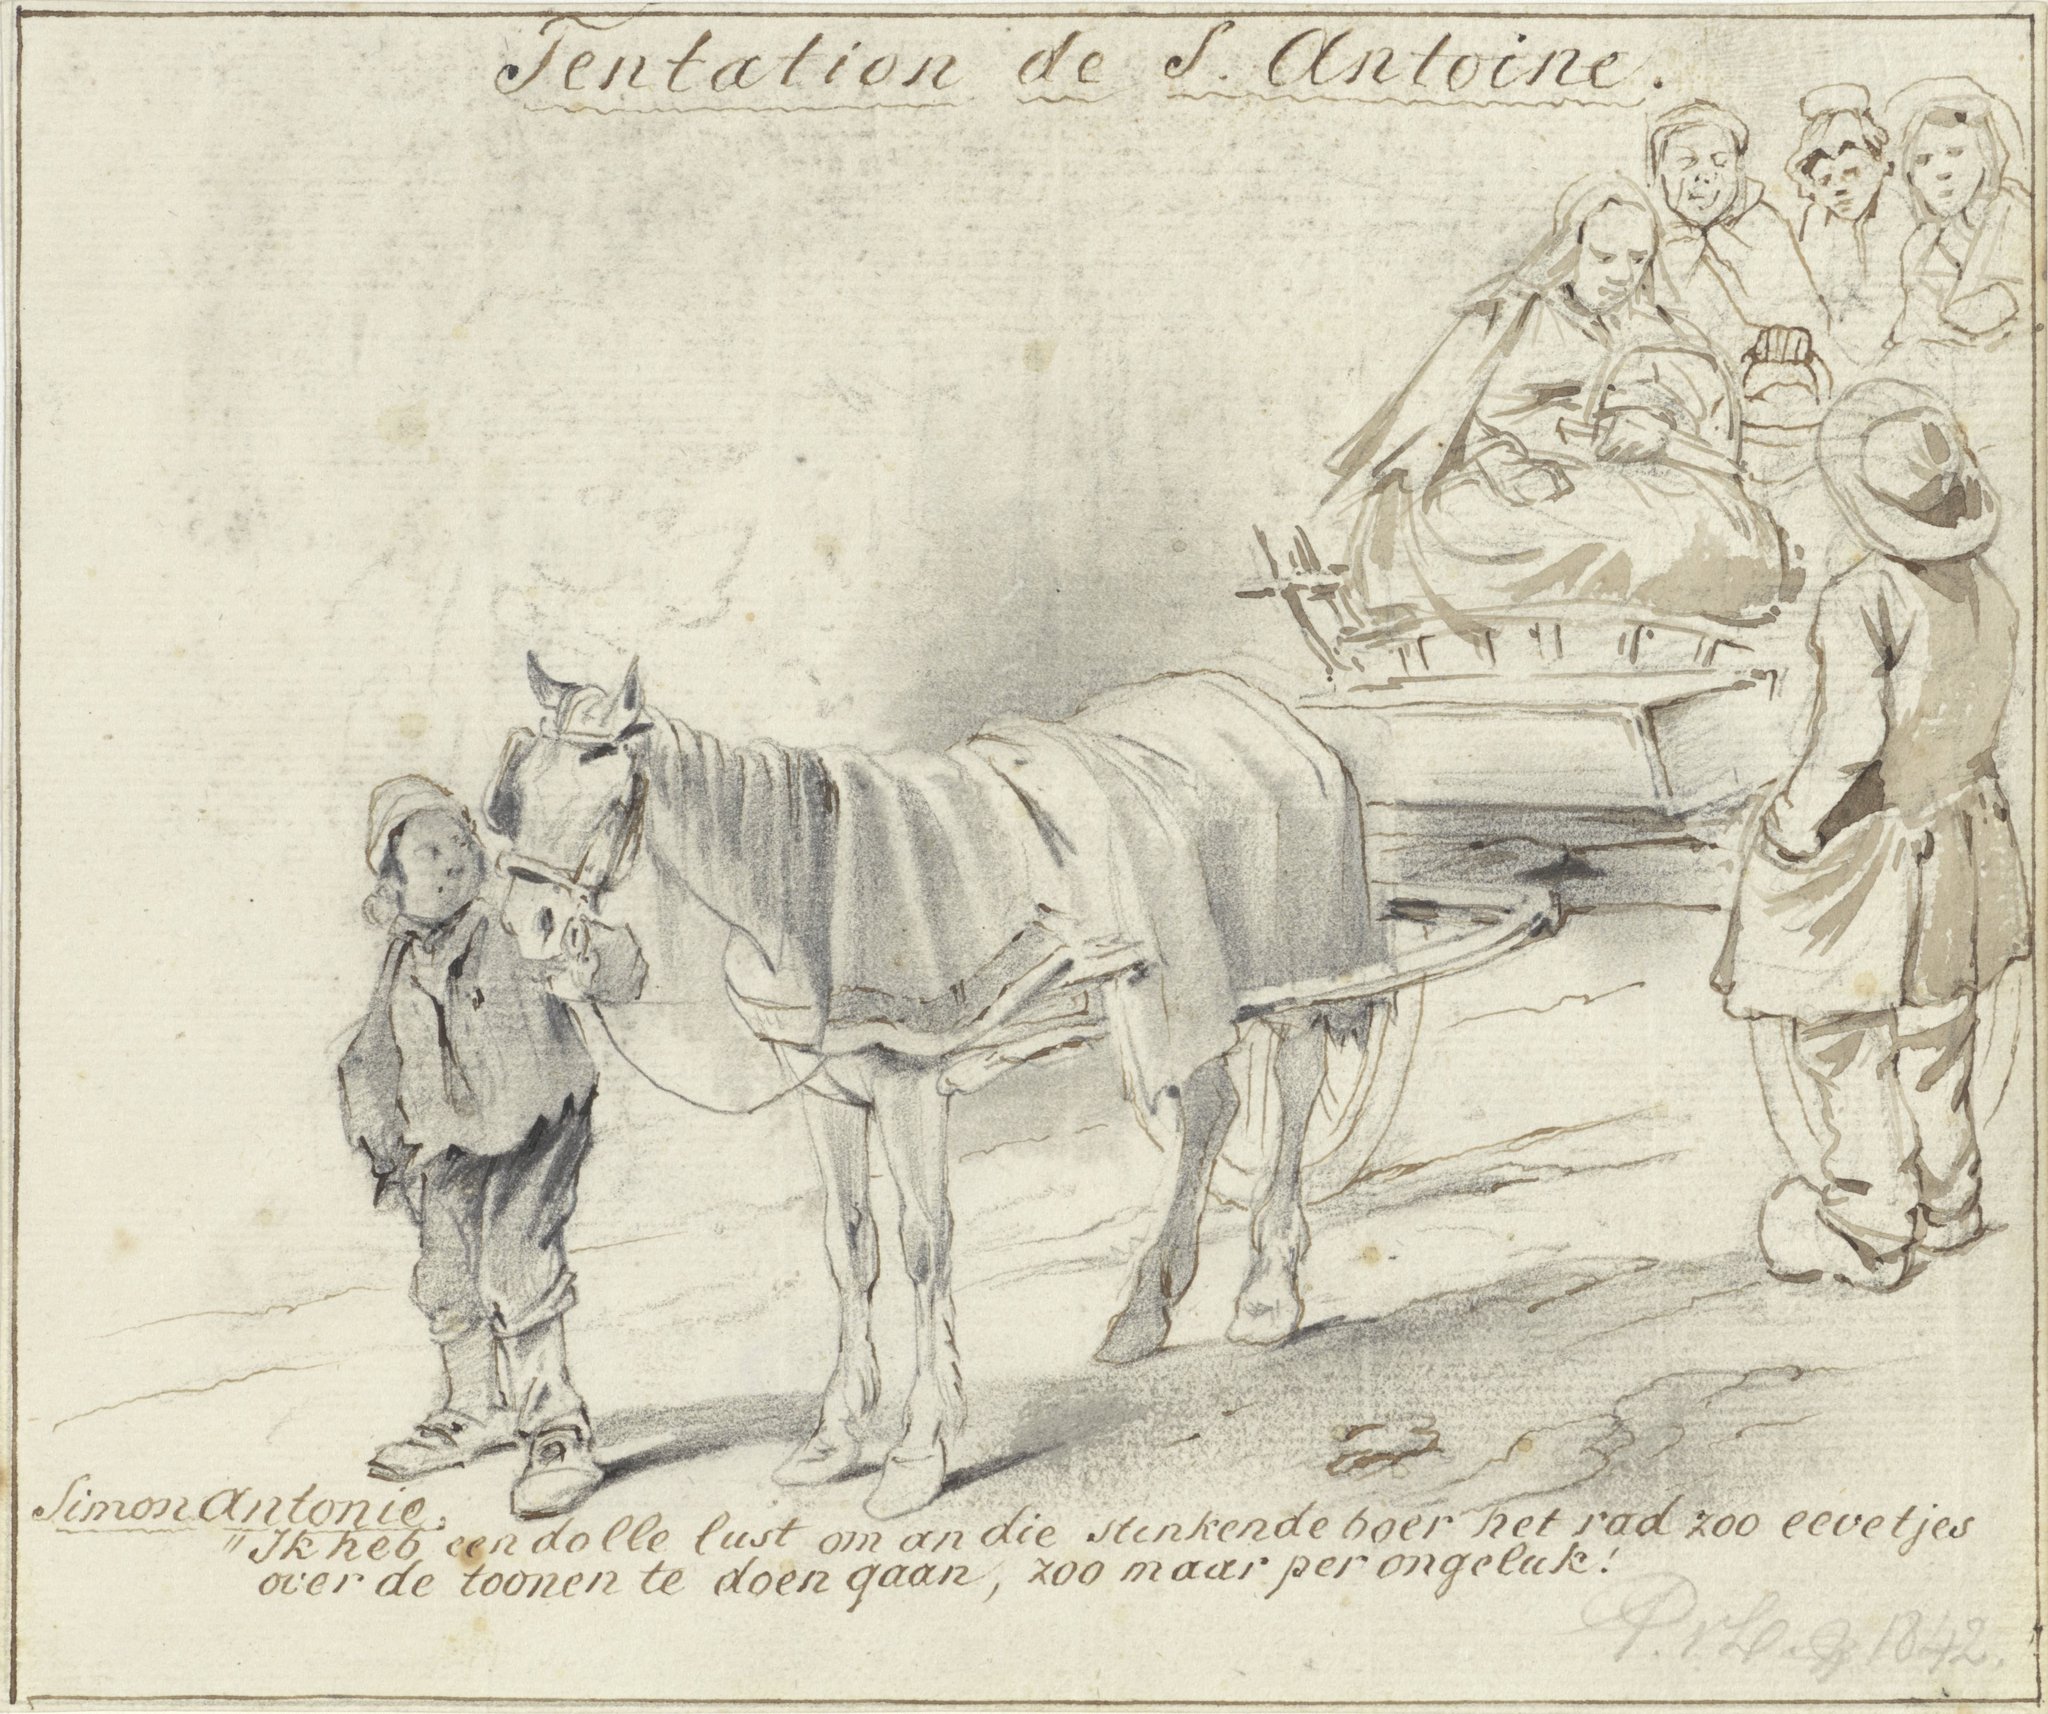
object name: drawing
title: Tentation de S. Antoine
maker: pieter van loon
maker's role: draughtsman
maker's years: 1801-1873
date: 1842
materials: paper, pencil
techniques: brush, pen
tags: (farm) wagon, freight wagon, cart